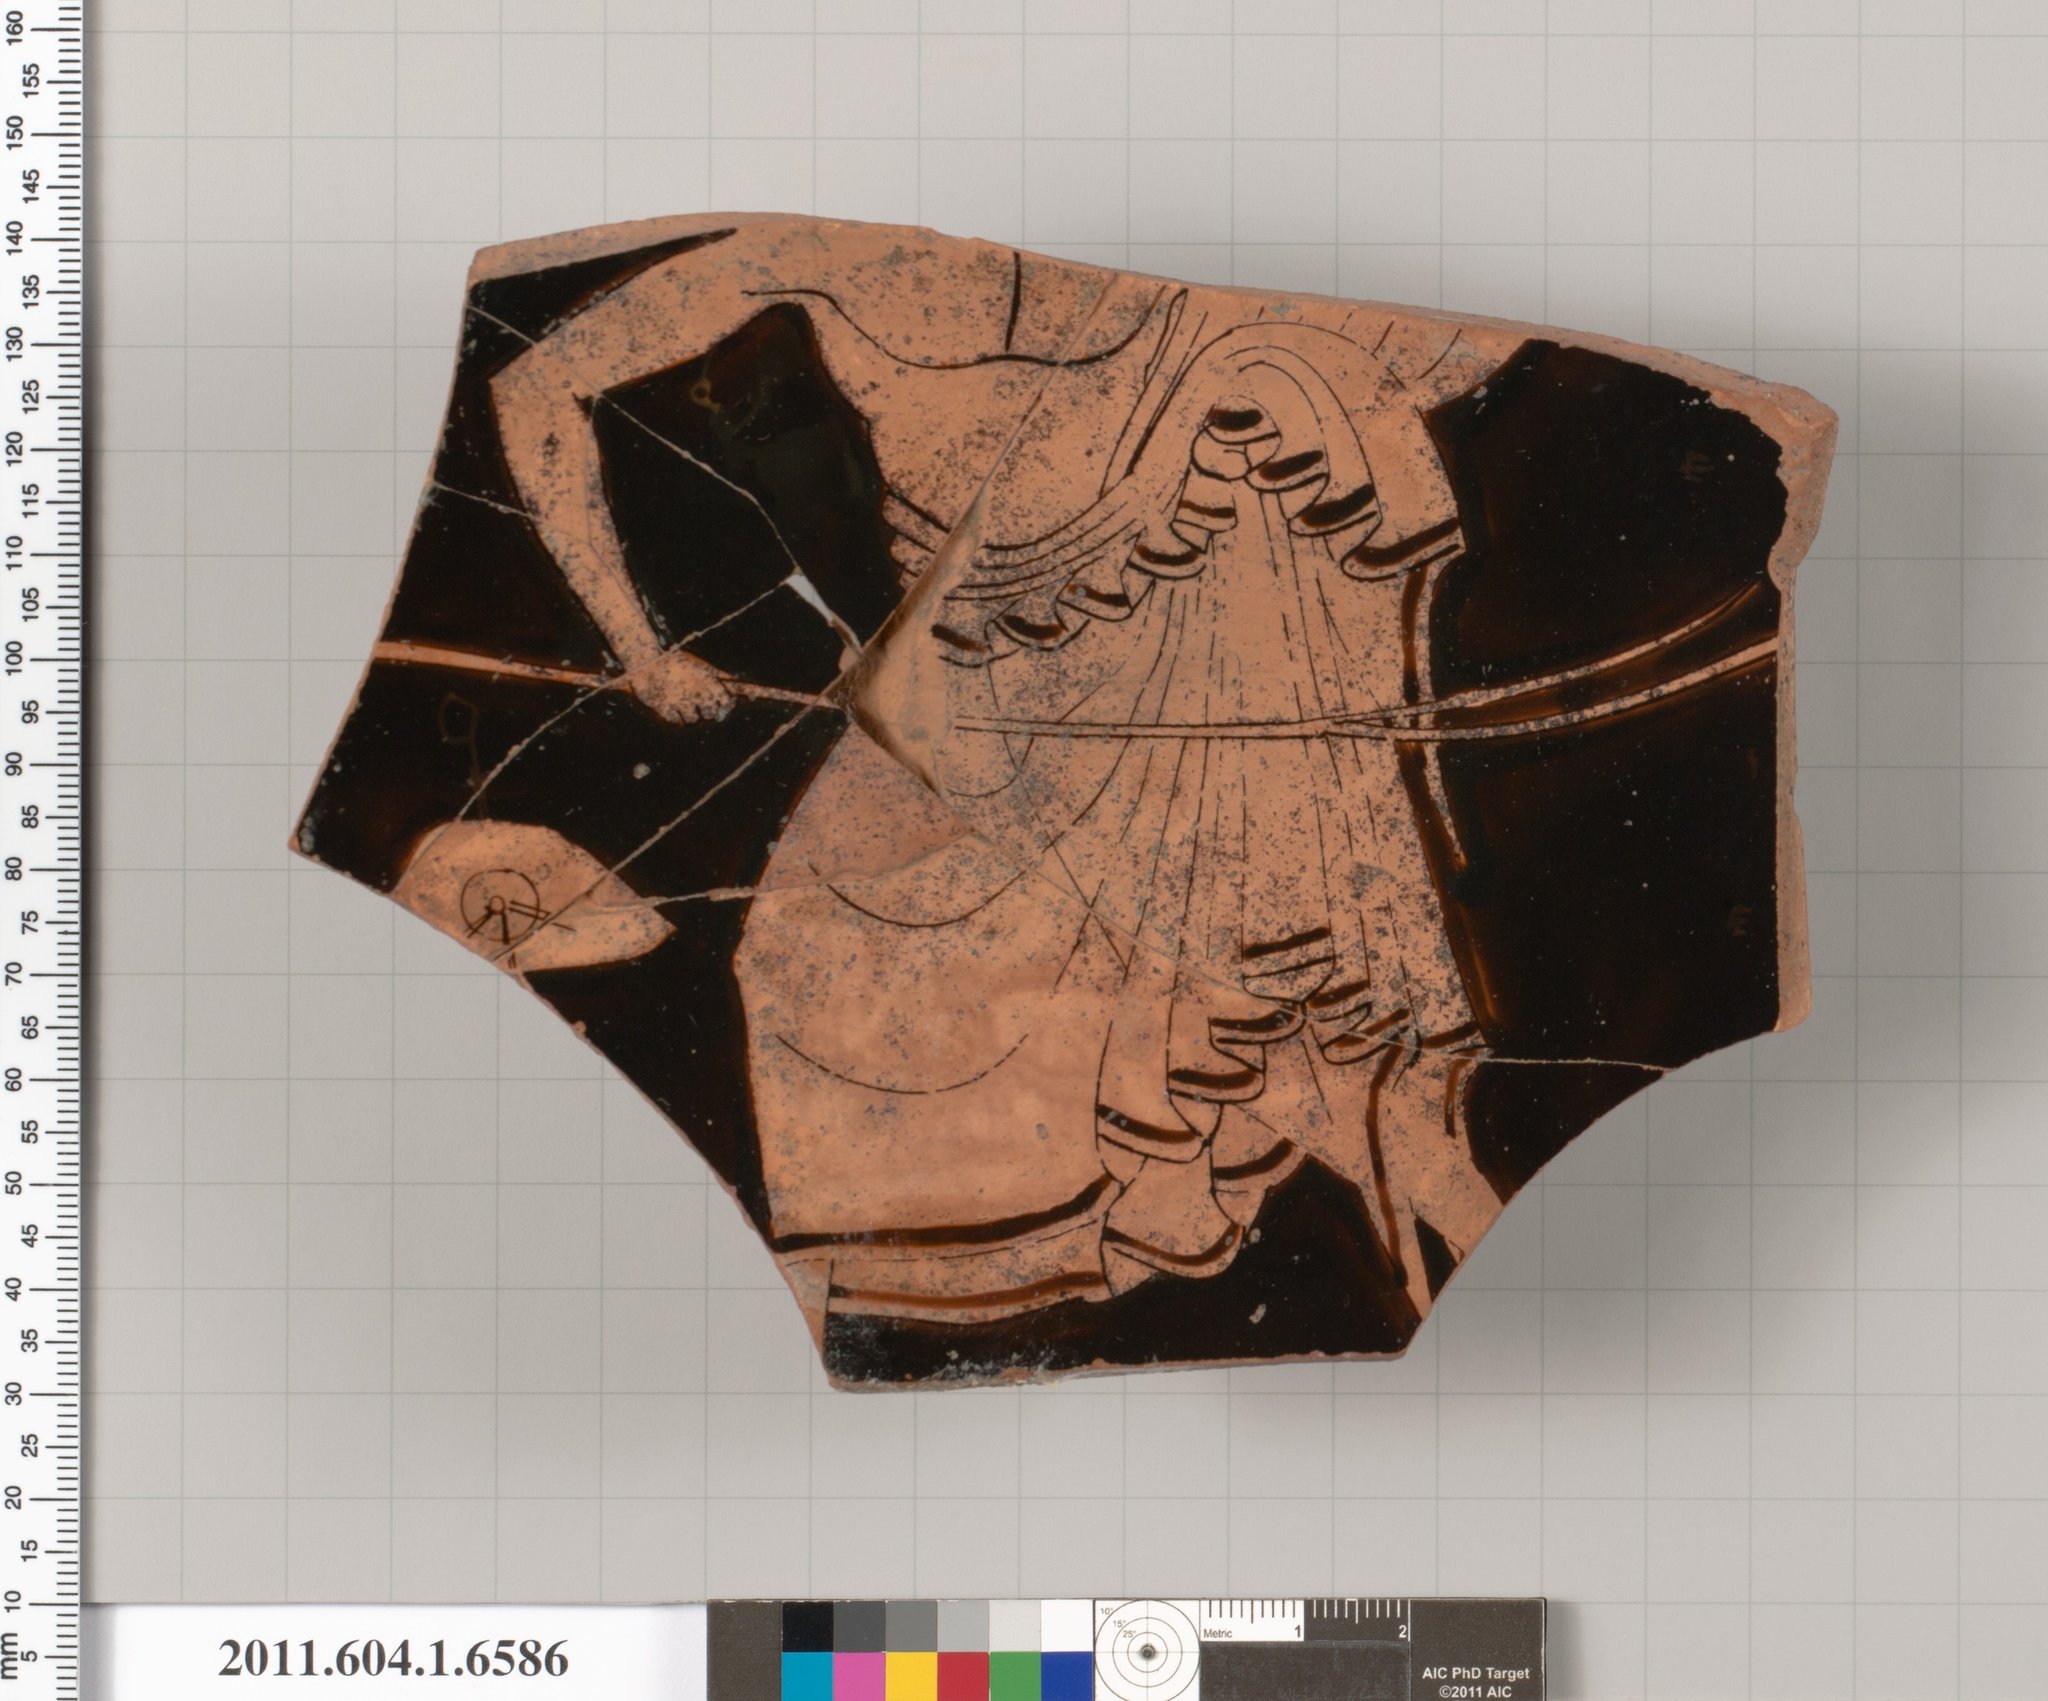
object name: kylix fragment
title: Terracotta fragment of a kylix (drinking cup)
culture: greek, attic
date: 490-480 BCE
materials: terracotta